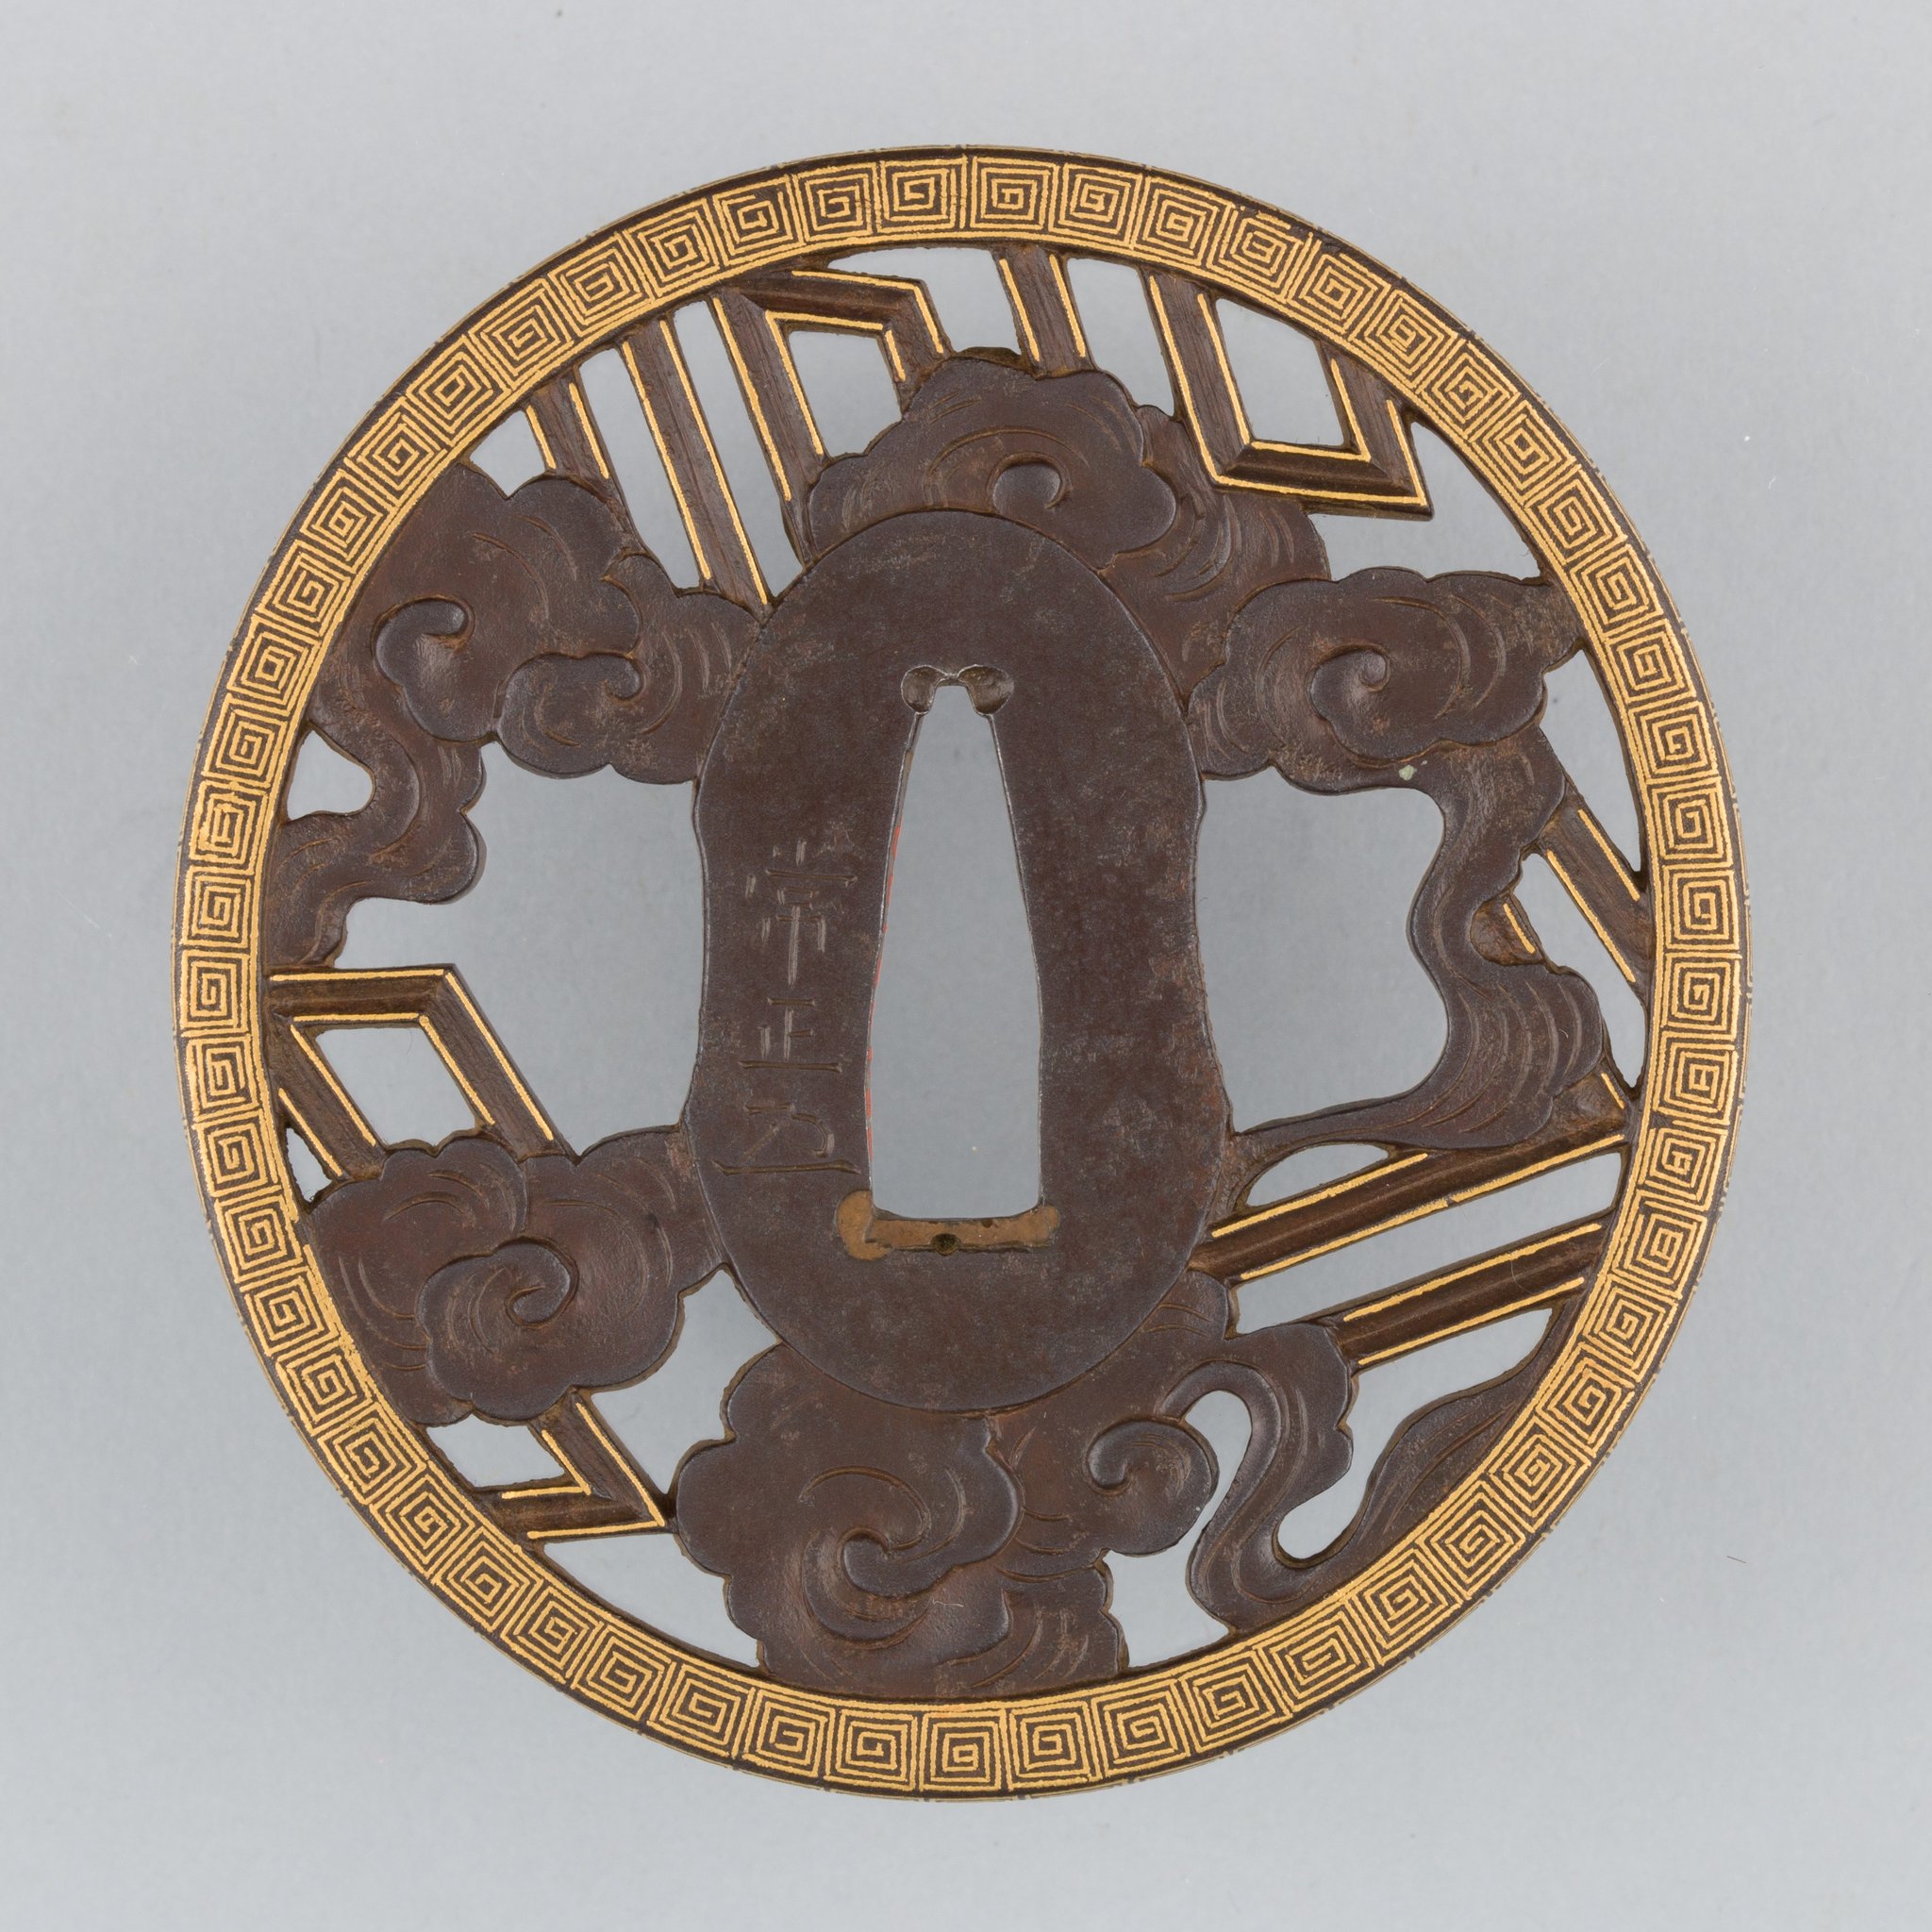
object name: sword guard tsuba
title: Sword Guard (Tsuba)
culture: japanese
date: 1800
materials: copper, gold, iron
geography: japan